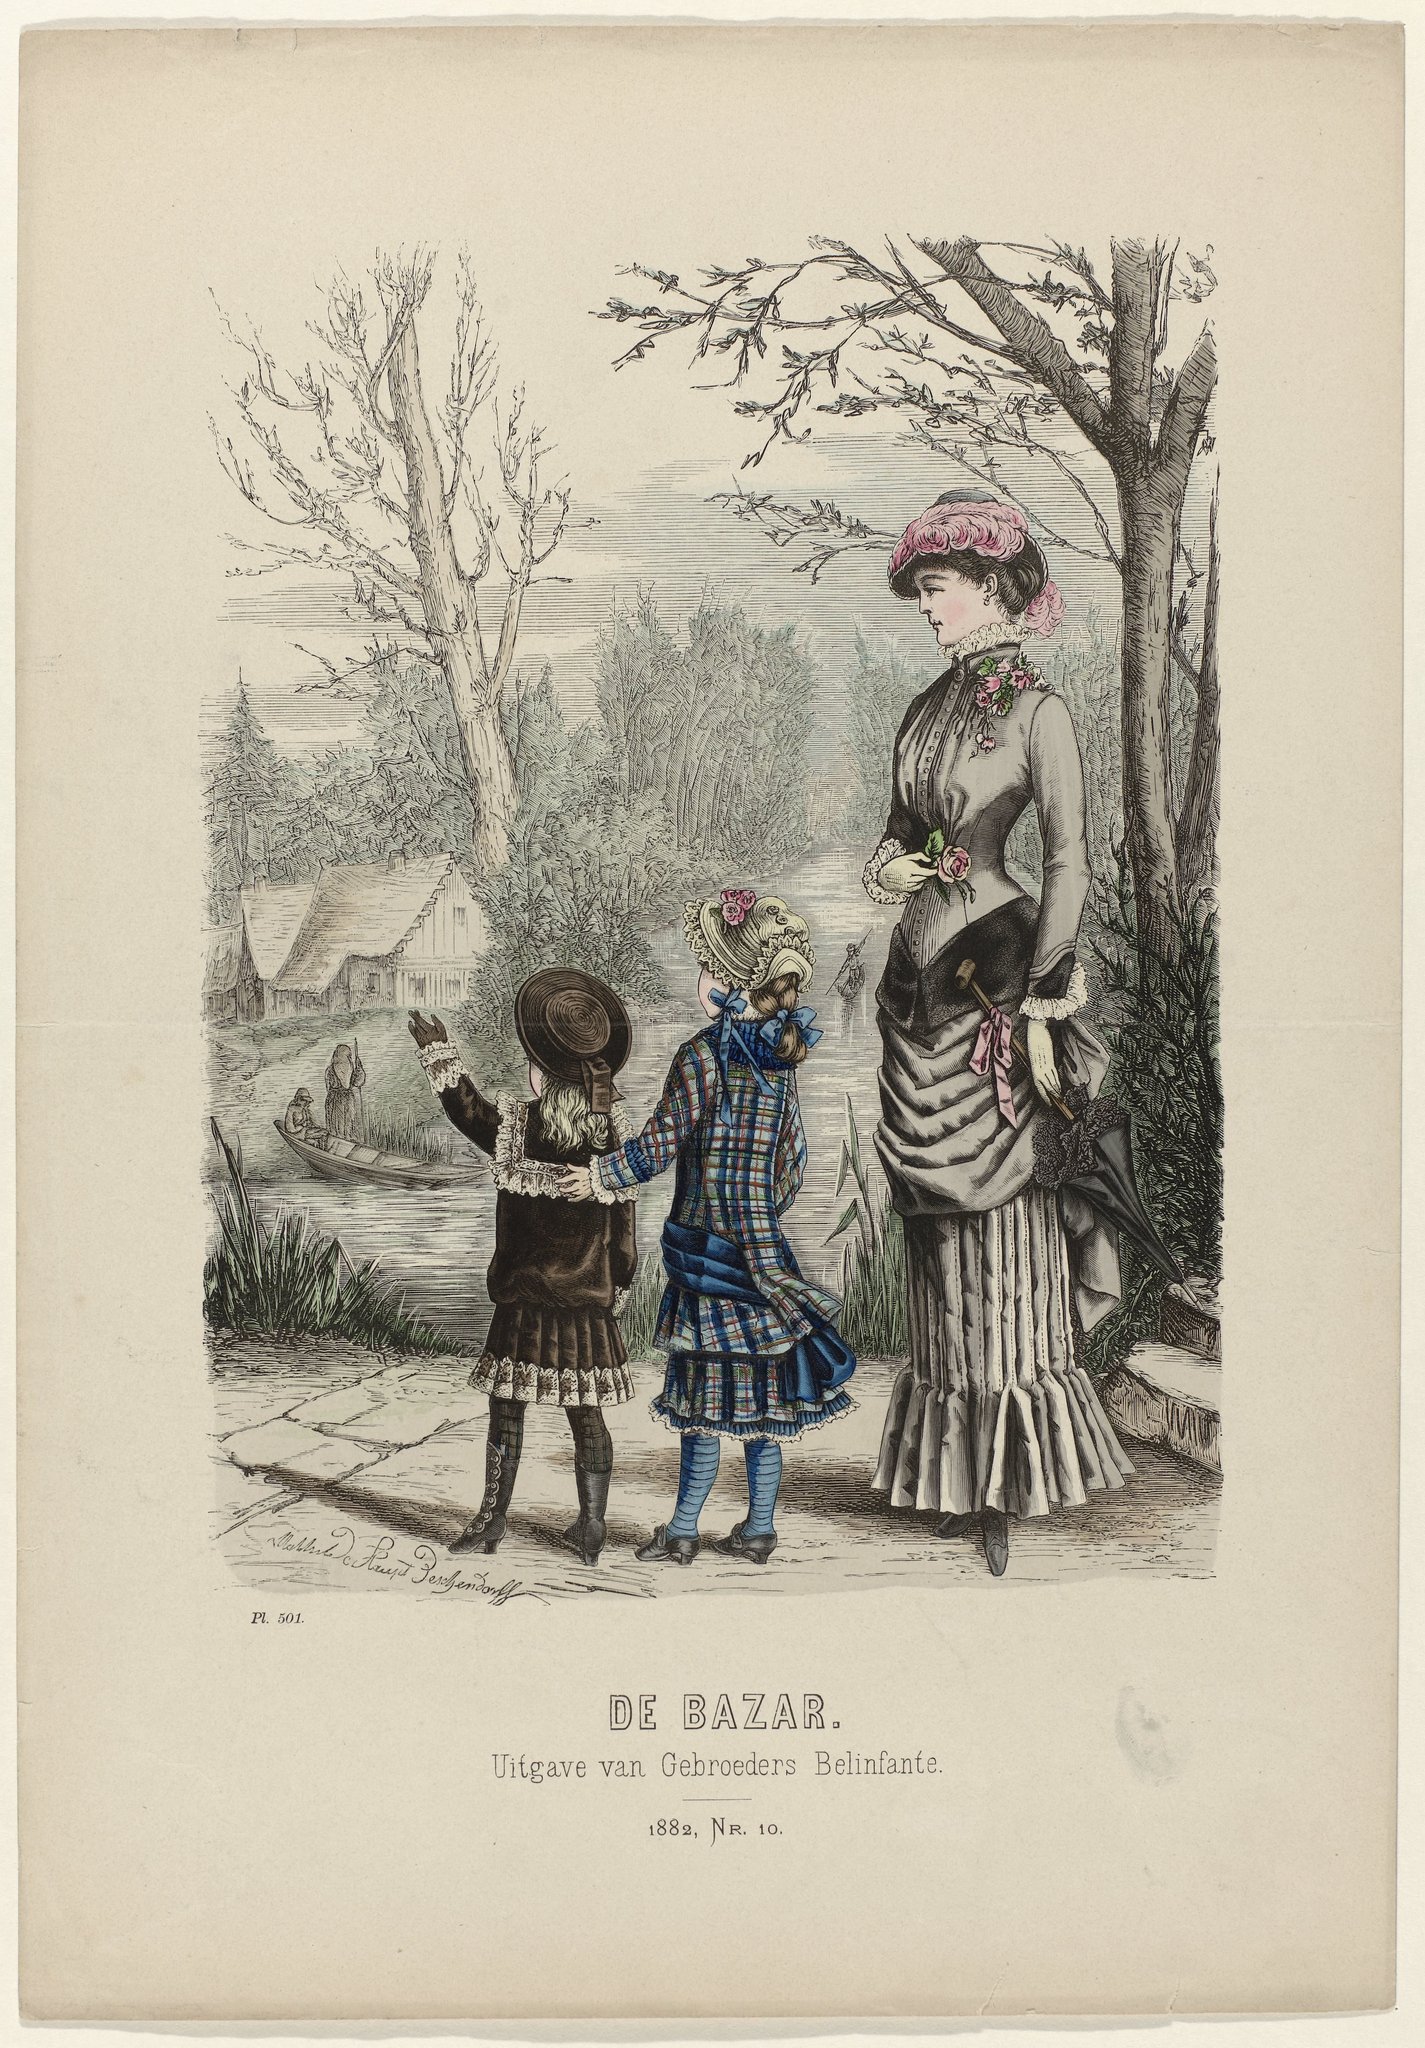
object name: fashion print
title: De Bazar, 1882, Nr. 10, Pl. 501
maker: Anonymous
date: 1882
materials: paper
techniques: hand coloring, engraving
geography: the hague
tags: corsage (+ women's clothes), cut flowers; nosegay, bunch of flowers, head-gear: hat (+ girls' clothes), stockings, socks (+ girls' clothes), river, boots (+ girls' clothes), fashion plates, head-gear: hat (+ women's clothes), dress, gown (+ women's clothes), parasol, sunshade (+ women's clothes), dress, gown (+ girls' clothes)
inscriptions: caption: ‘DE BAZAR. / Uitgave van Gebroeders Belinfante. / 1882, Nr. 10’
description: Vrouw en twee kinderen in wandelkostuum. Prent uit het modetijdschrift De Bazar, geïllustreerd Tijdschrift voor Modes en Handwerken (1857-1900).